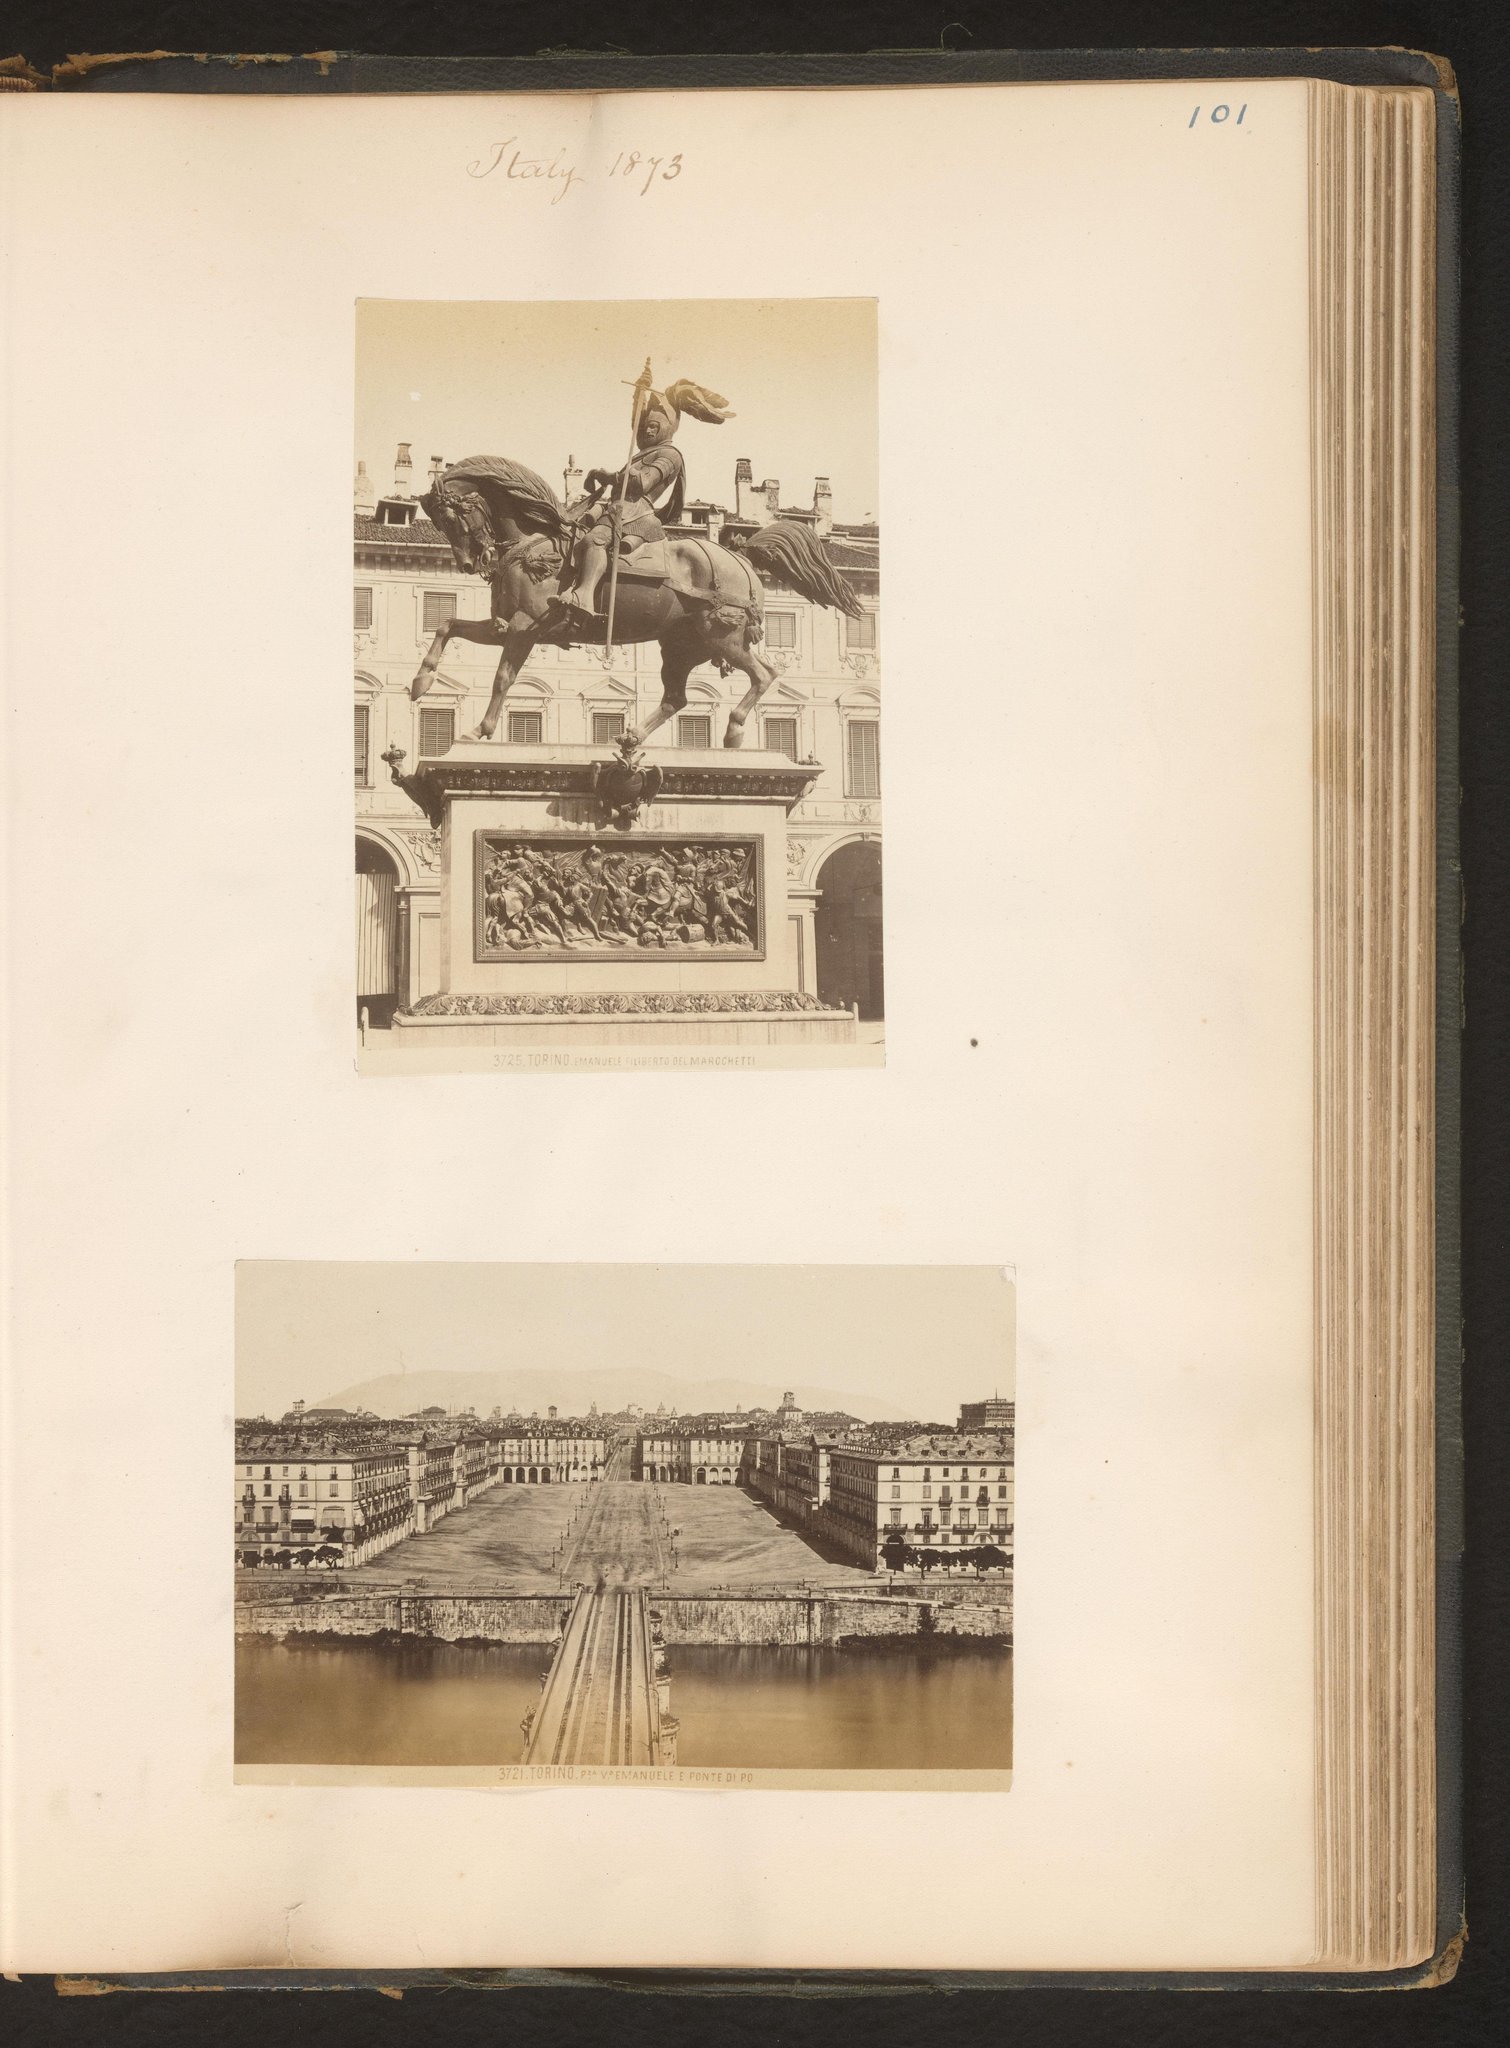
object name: photograph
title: Monument voor Emmanuel Philibert en gezicht op een brug te Turijn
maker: Anonymous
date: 1873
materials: paper, photographic support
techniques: albumen print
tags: monument, statue, bridge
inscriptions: inscription: ‘3725 Torino. Emanuelle Filiberto del Marochetti’, inscription: ‘3721 Torino. Pza Vo Emanuelle e ponte di Po’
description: Deze pagina maakt deel uit van een album.